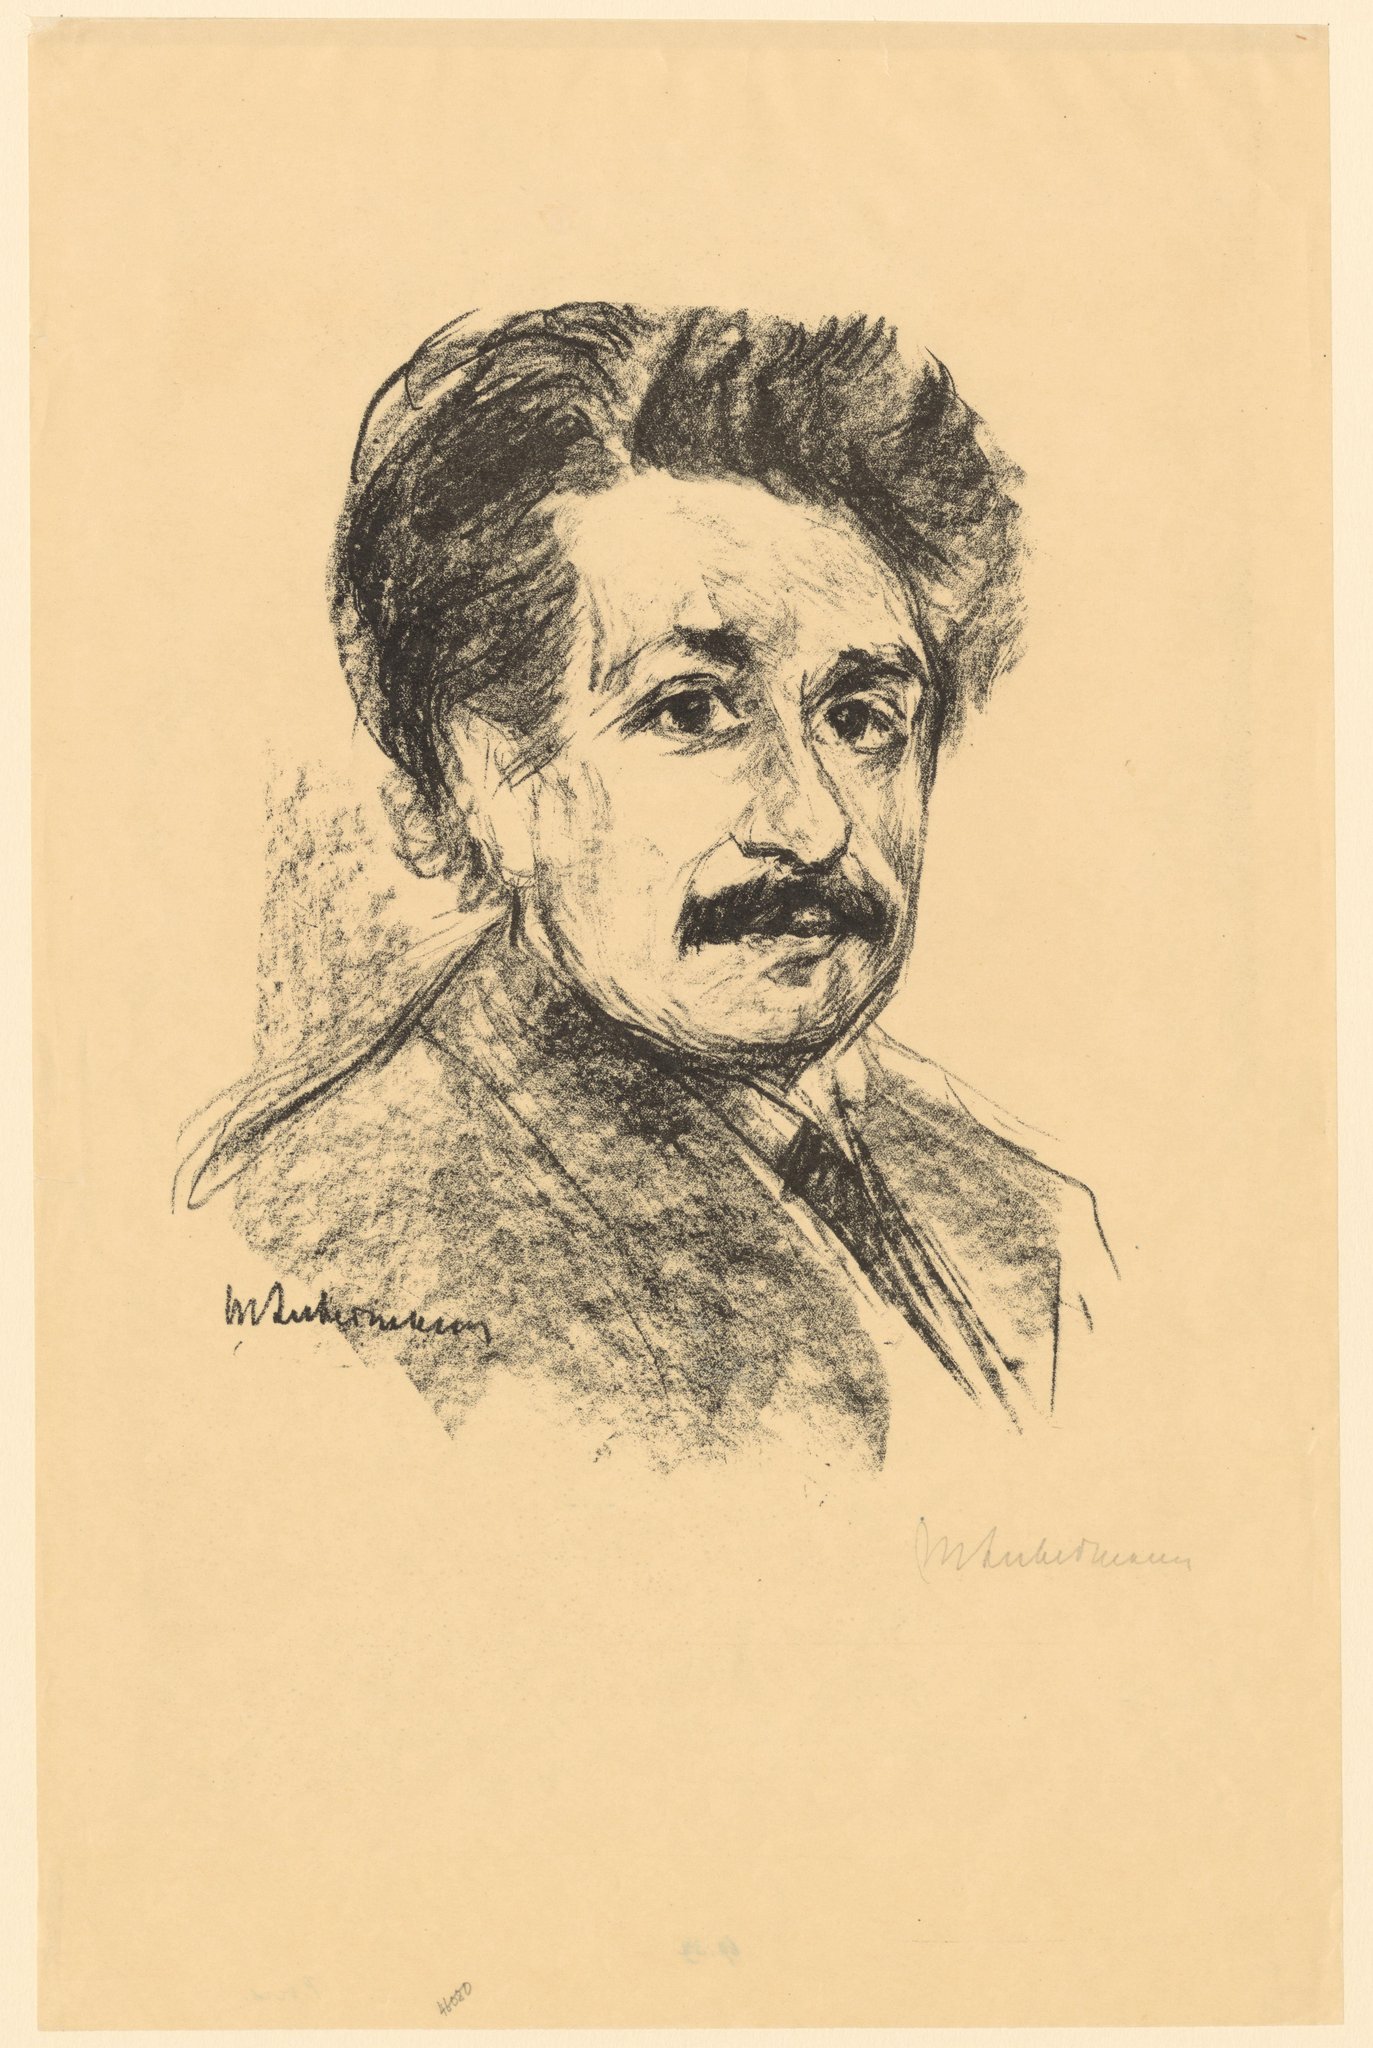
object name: print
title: Portret van Albert Einstein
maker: max liebermann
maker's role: draughtsman, print maker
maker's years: 1847-1935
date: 1857-1935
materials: paper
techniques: lithograph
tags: scholar, philosopher, historical persons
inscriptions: collector's mark: Lugt 2760, collector's mark: Lugt 2228